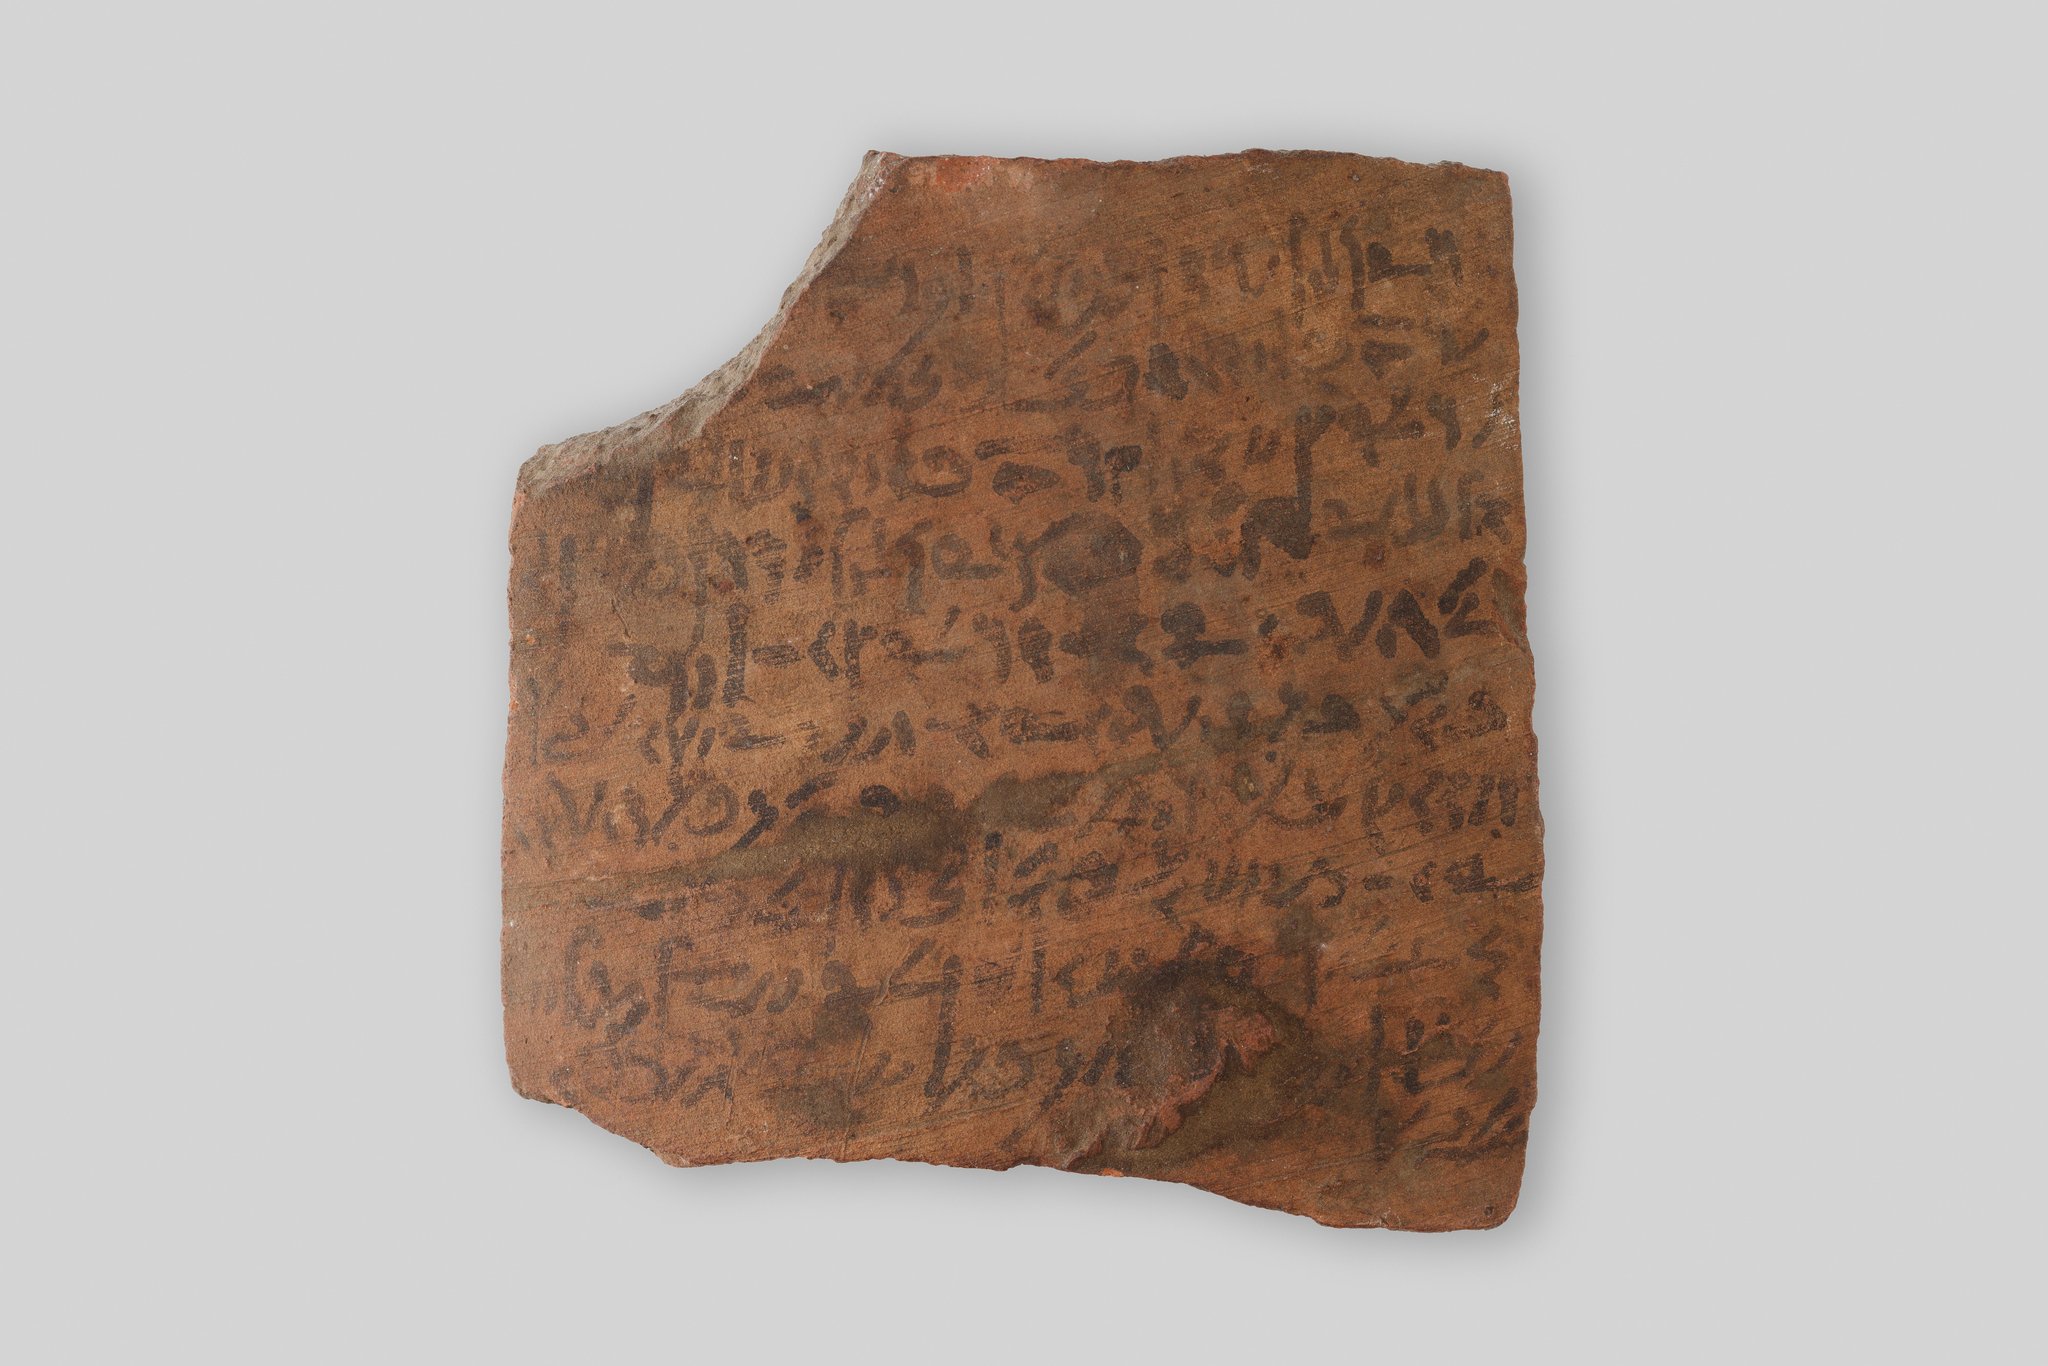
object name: ostracon, demotic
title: Ostracon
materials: ink, pottery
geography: egypt